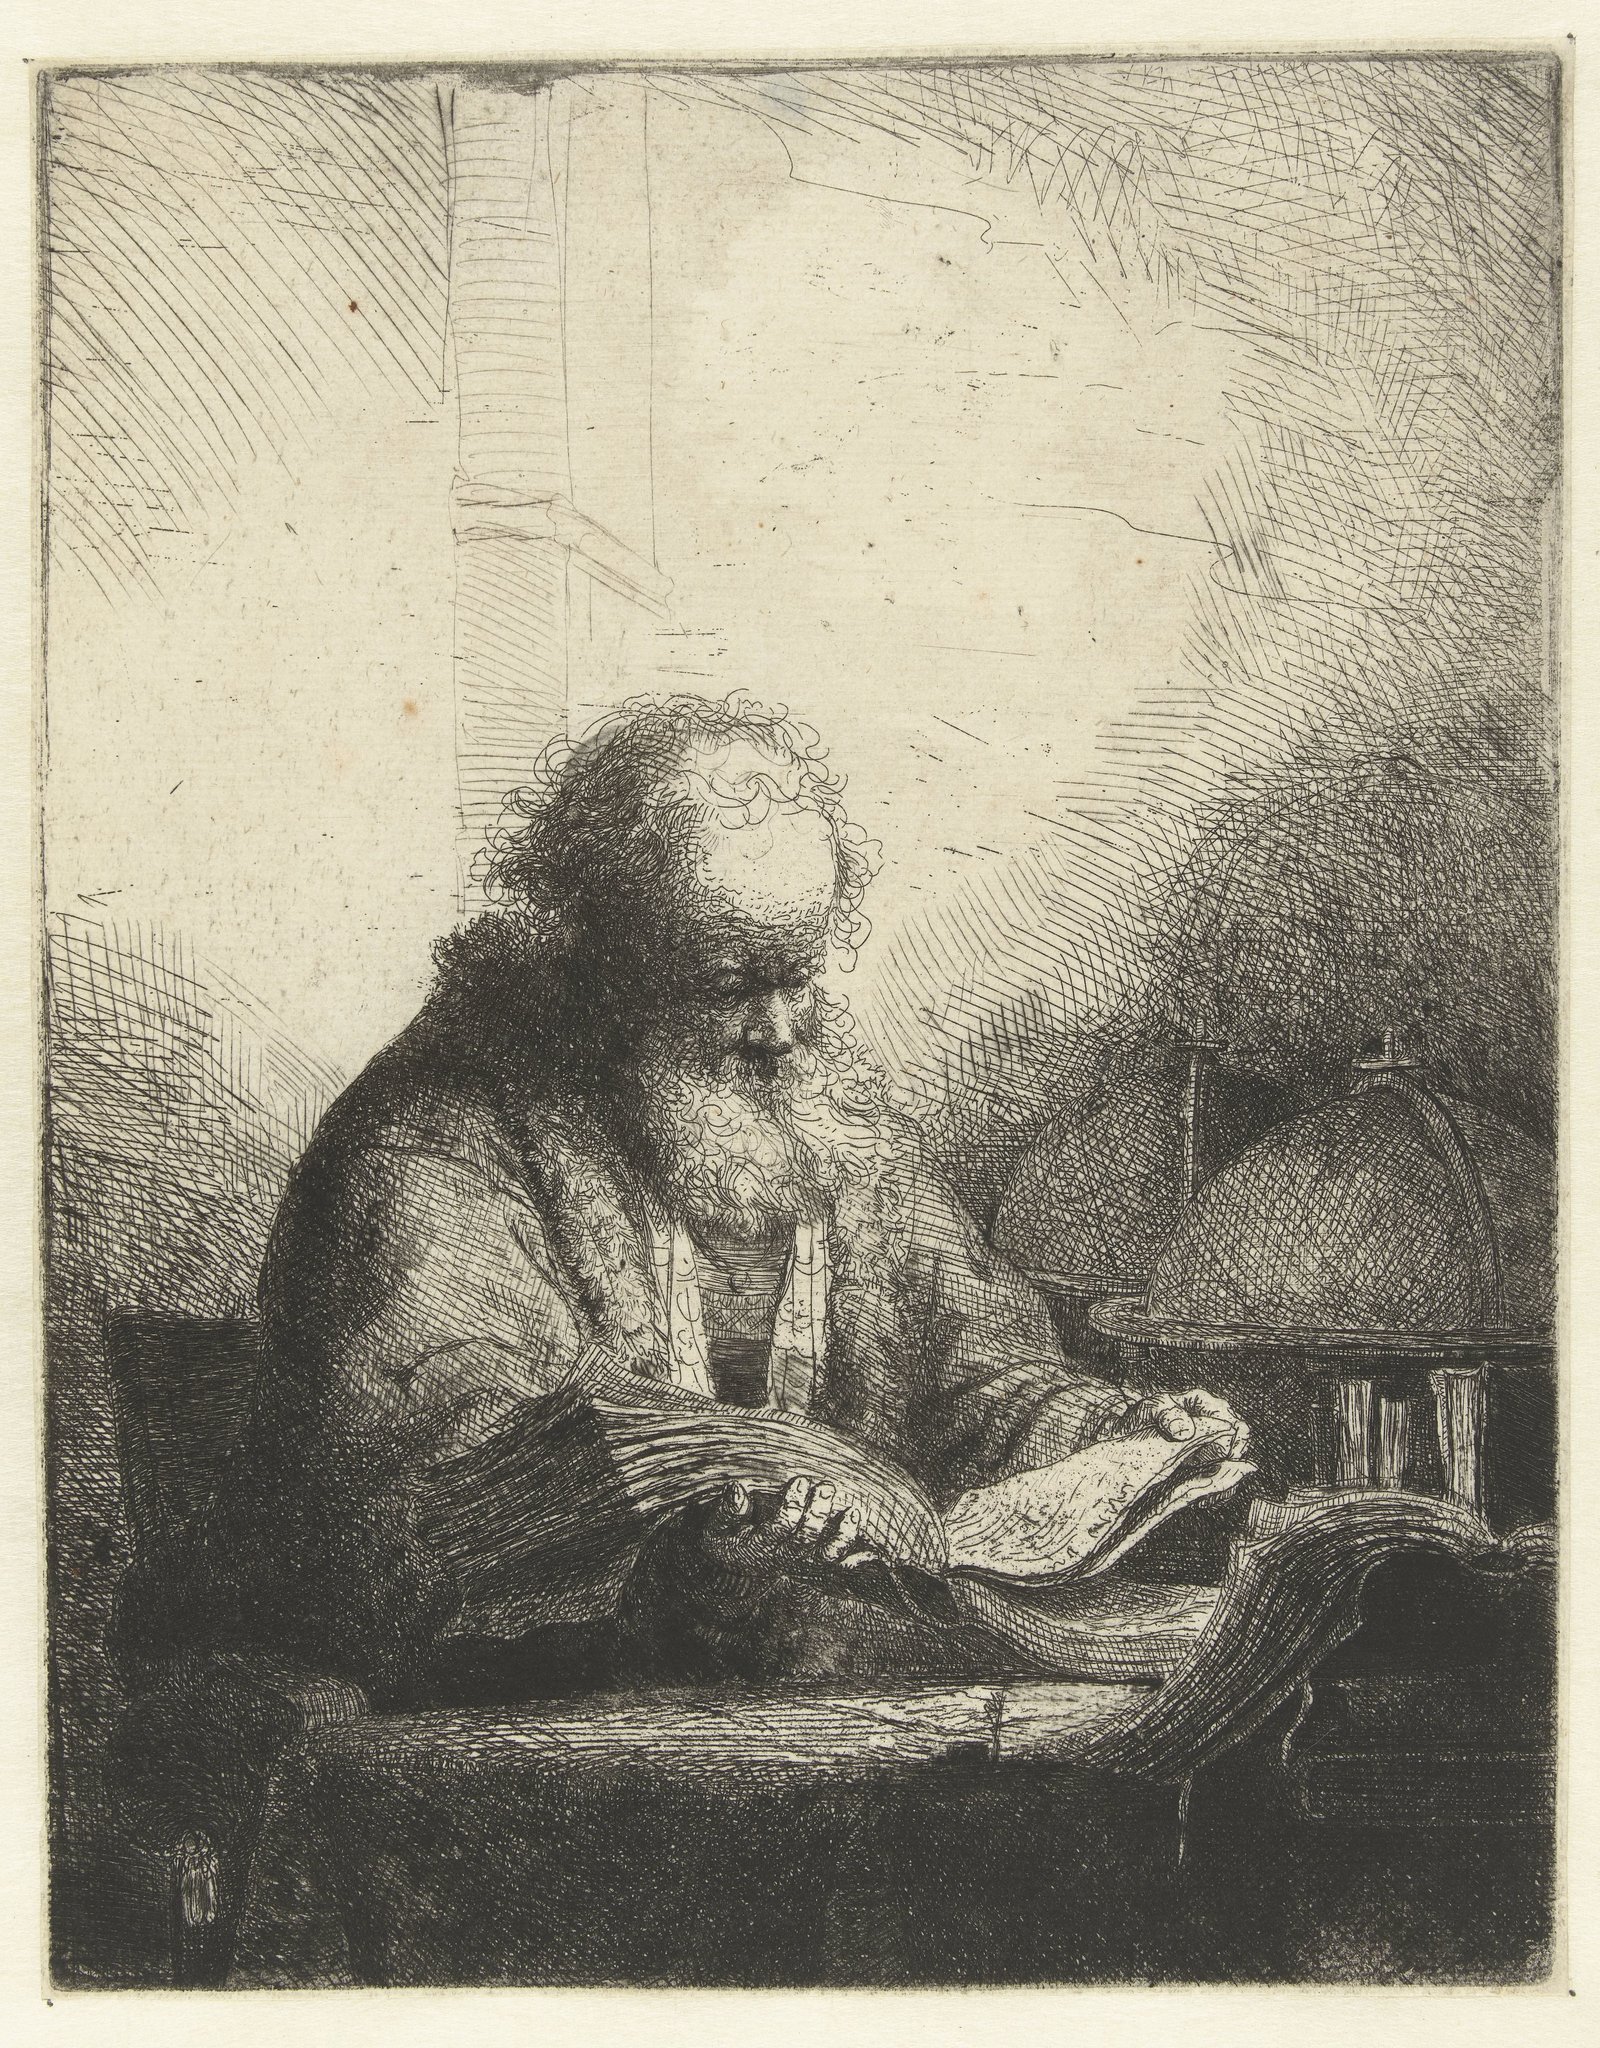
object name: print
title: Filosoof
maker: ferdinand bol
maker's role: draughtsman, painter, print maker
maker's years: 1616-1680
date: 1642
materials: paper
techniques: drypoint, etching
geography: amsterdam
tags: scholar, philosopher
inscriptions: collector's mark: Lugt 240